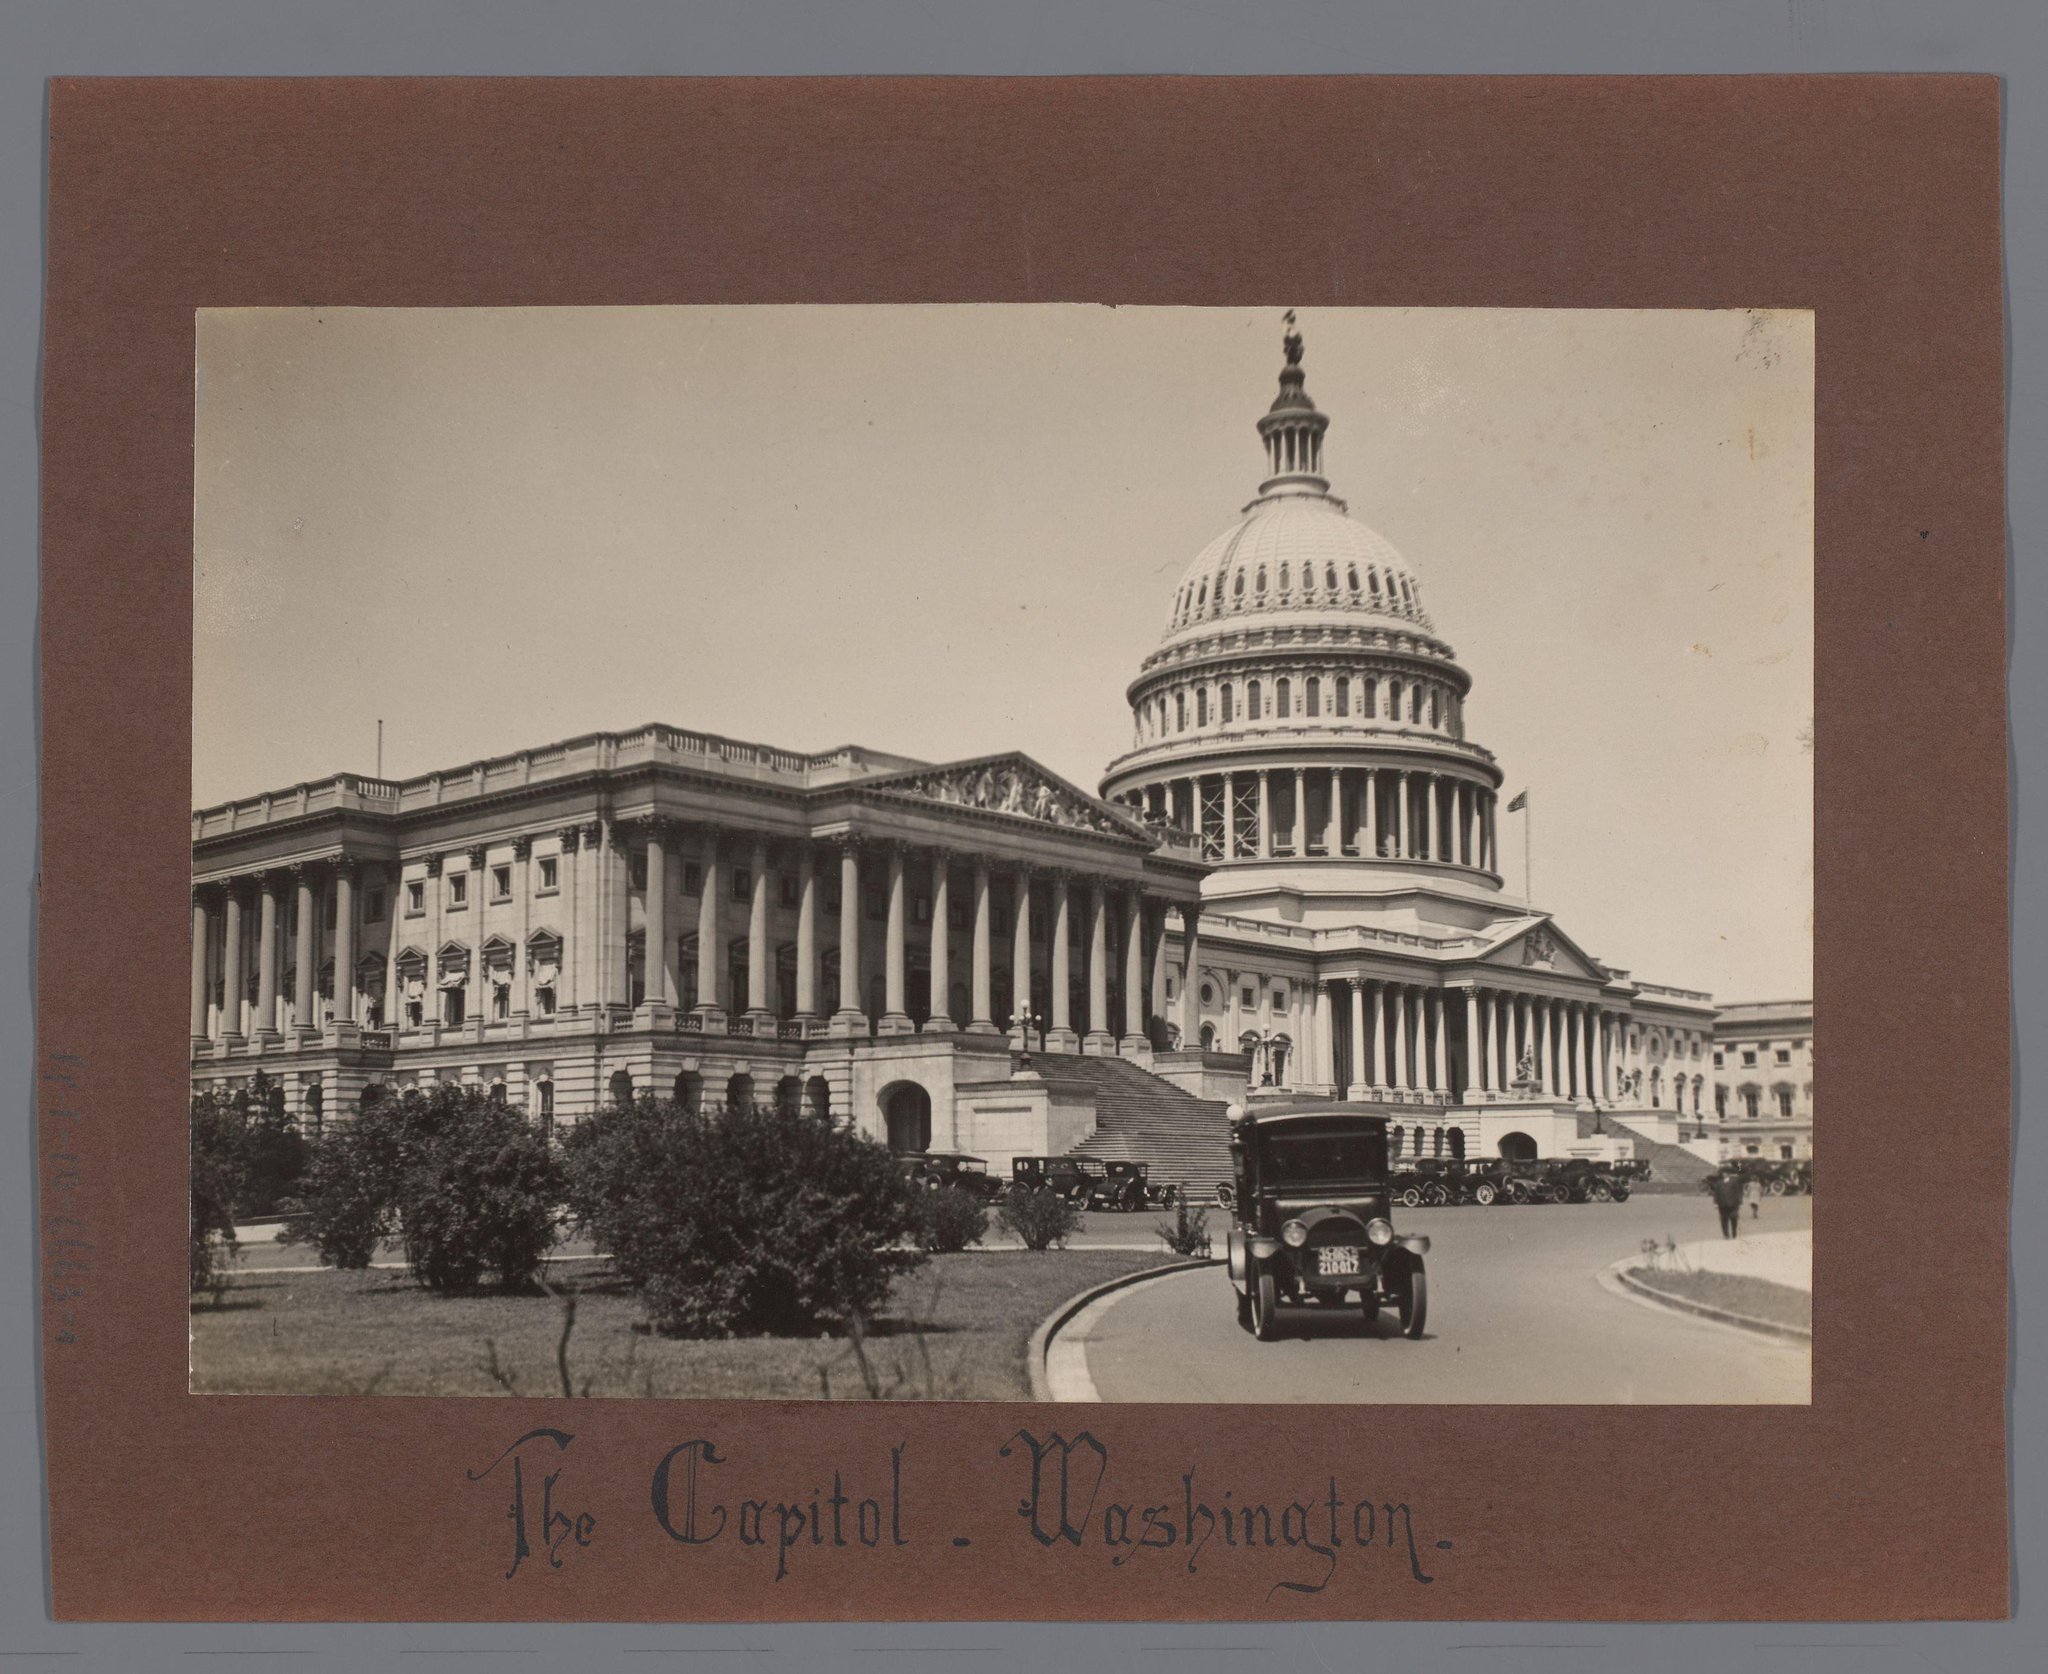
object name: photograph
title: Het Capitool, Washington D.C., Verenigde Staten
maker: Anonymous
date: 1900-1940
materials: cardboard, paper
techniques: albumen print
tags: washington d.c., capitool (washington d.c)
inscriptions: inscription: ‘The Capitol - Washington’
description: Het Capitool, Washington D.C., Verenigde Staten.